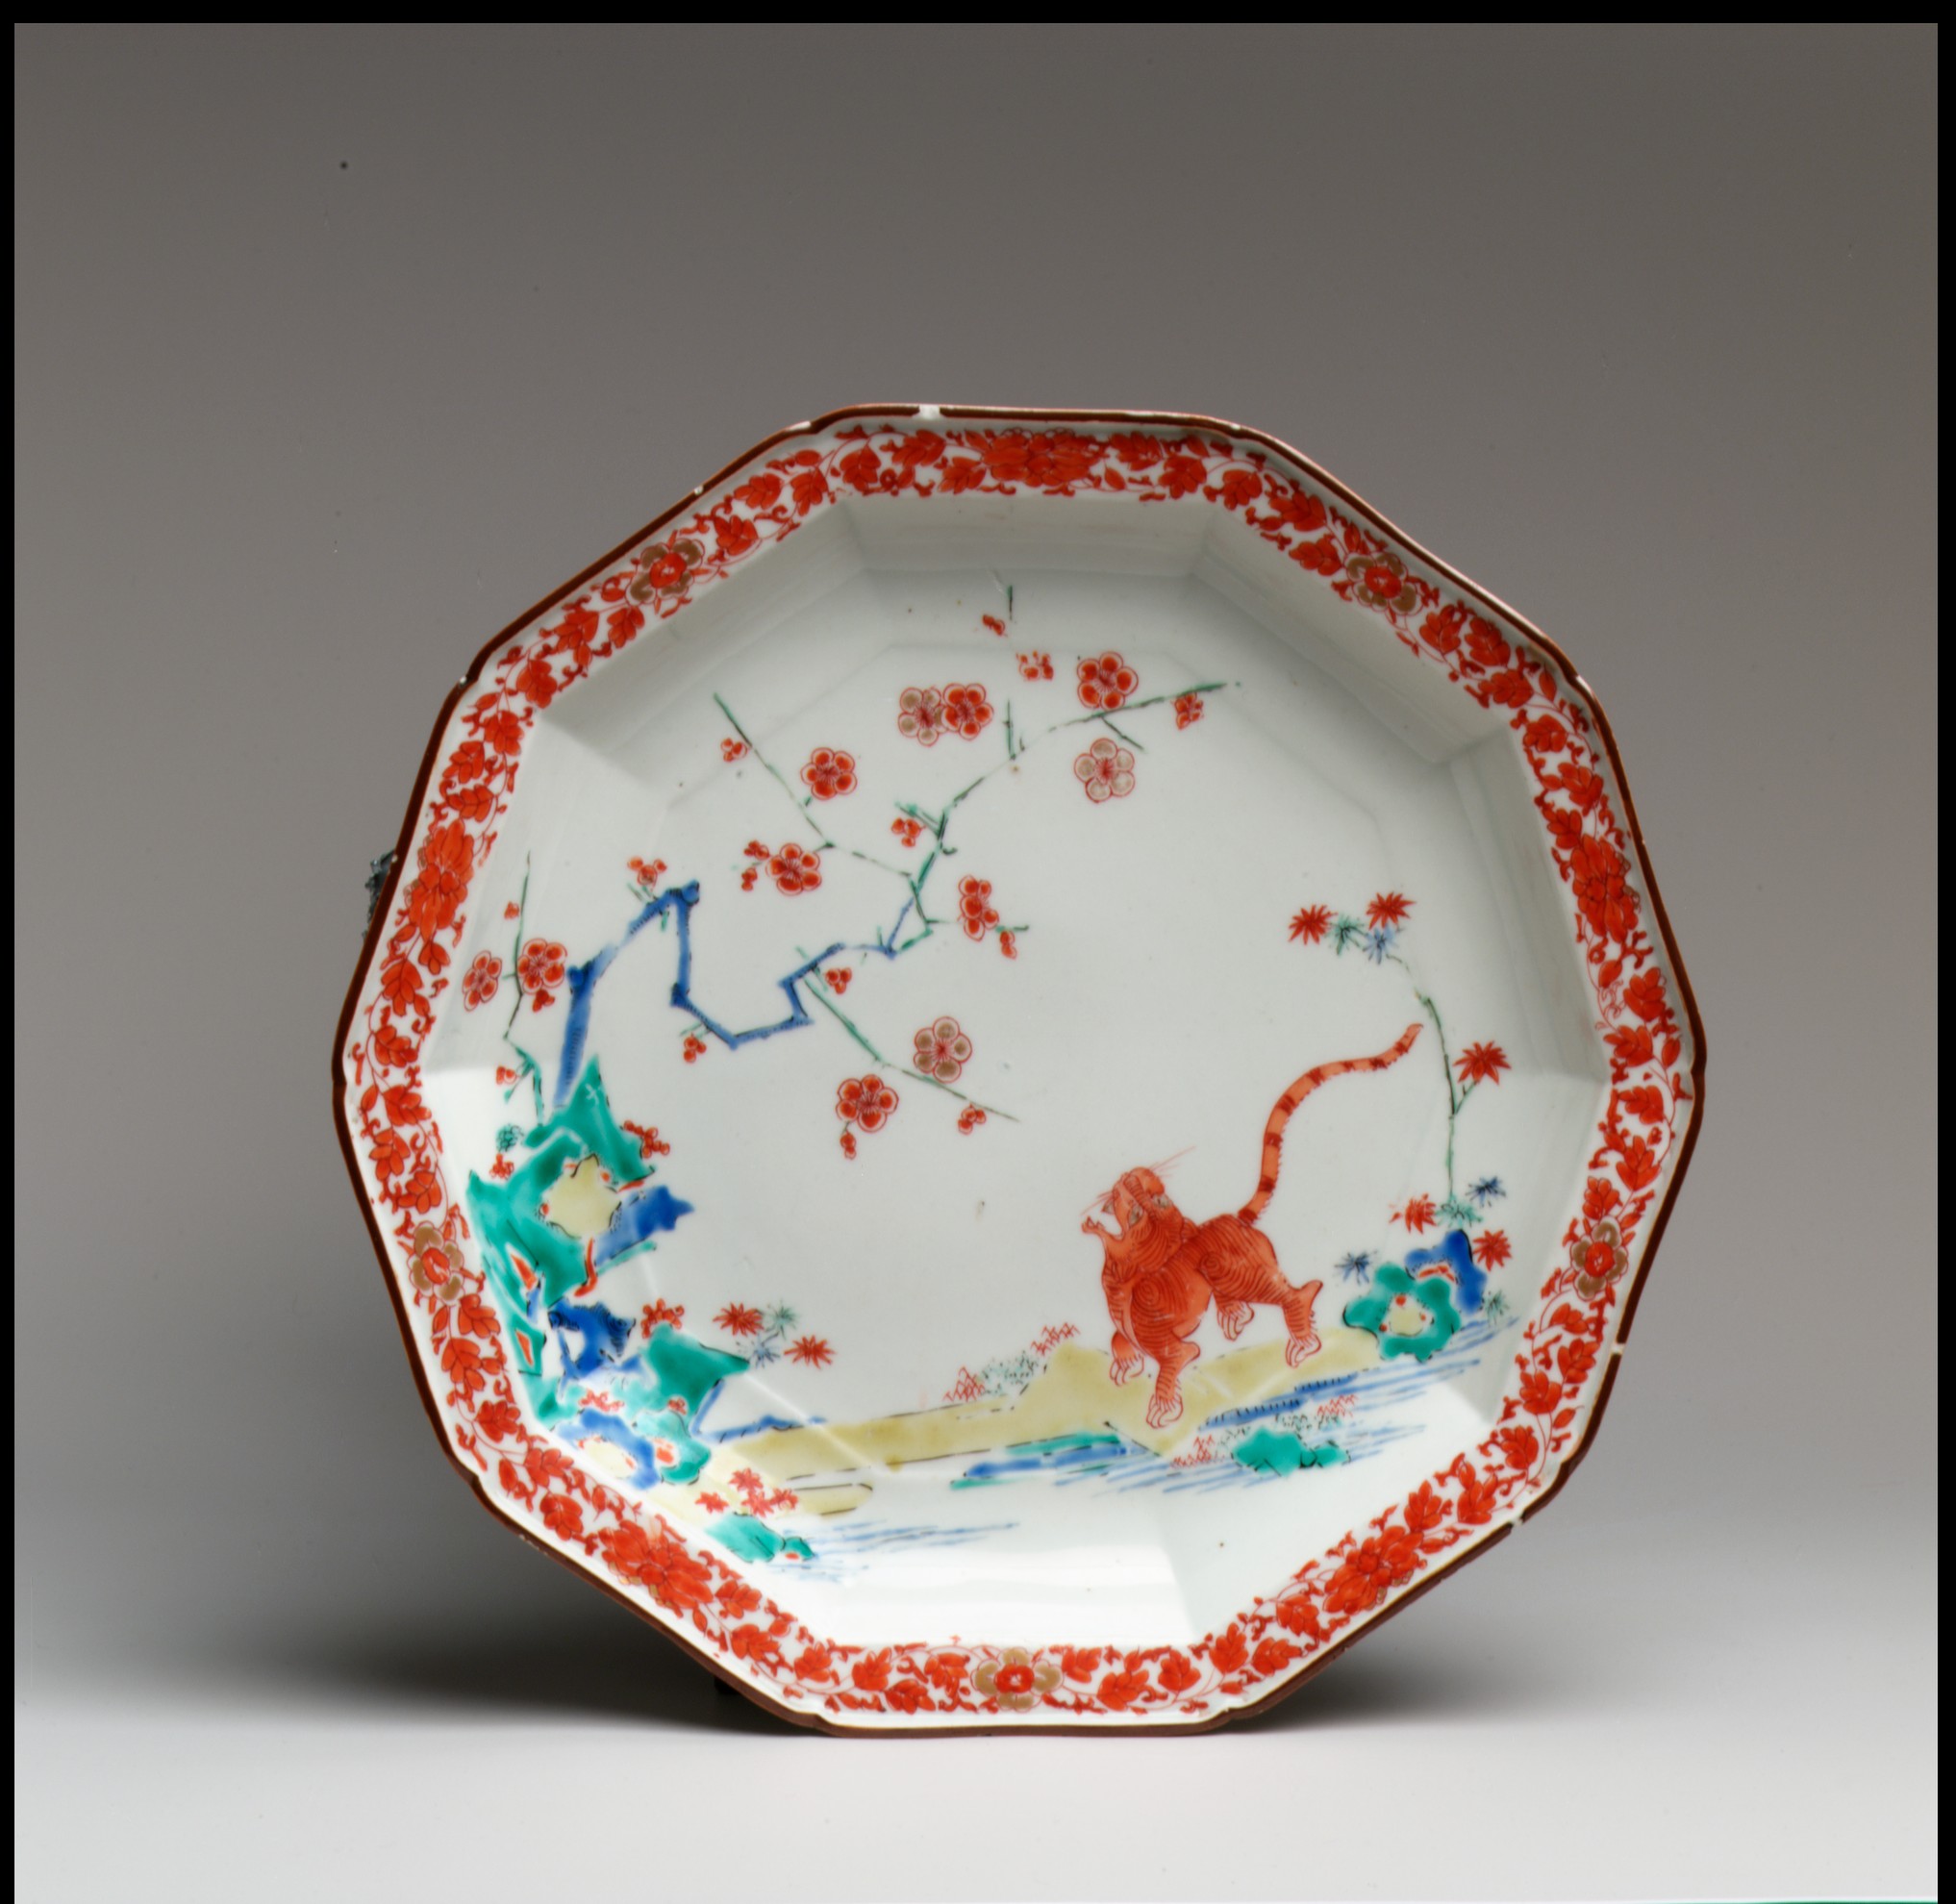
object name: dish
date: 1690-1710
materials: hard paste porcelain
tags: tigers,flowers